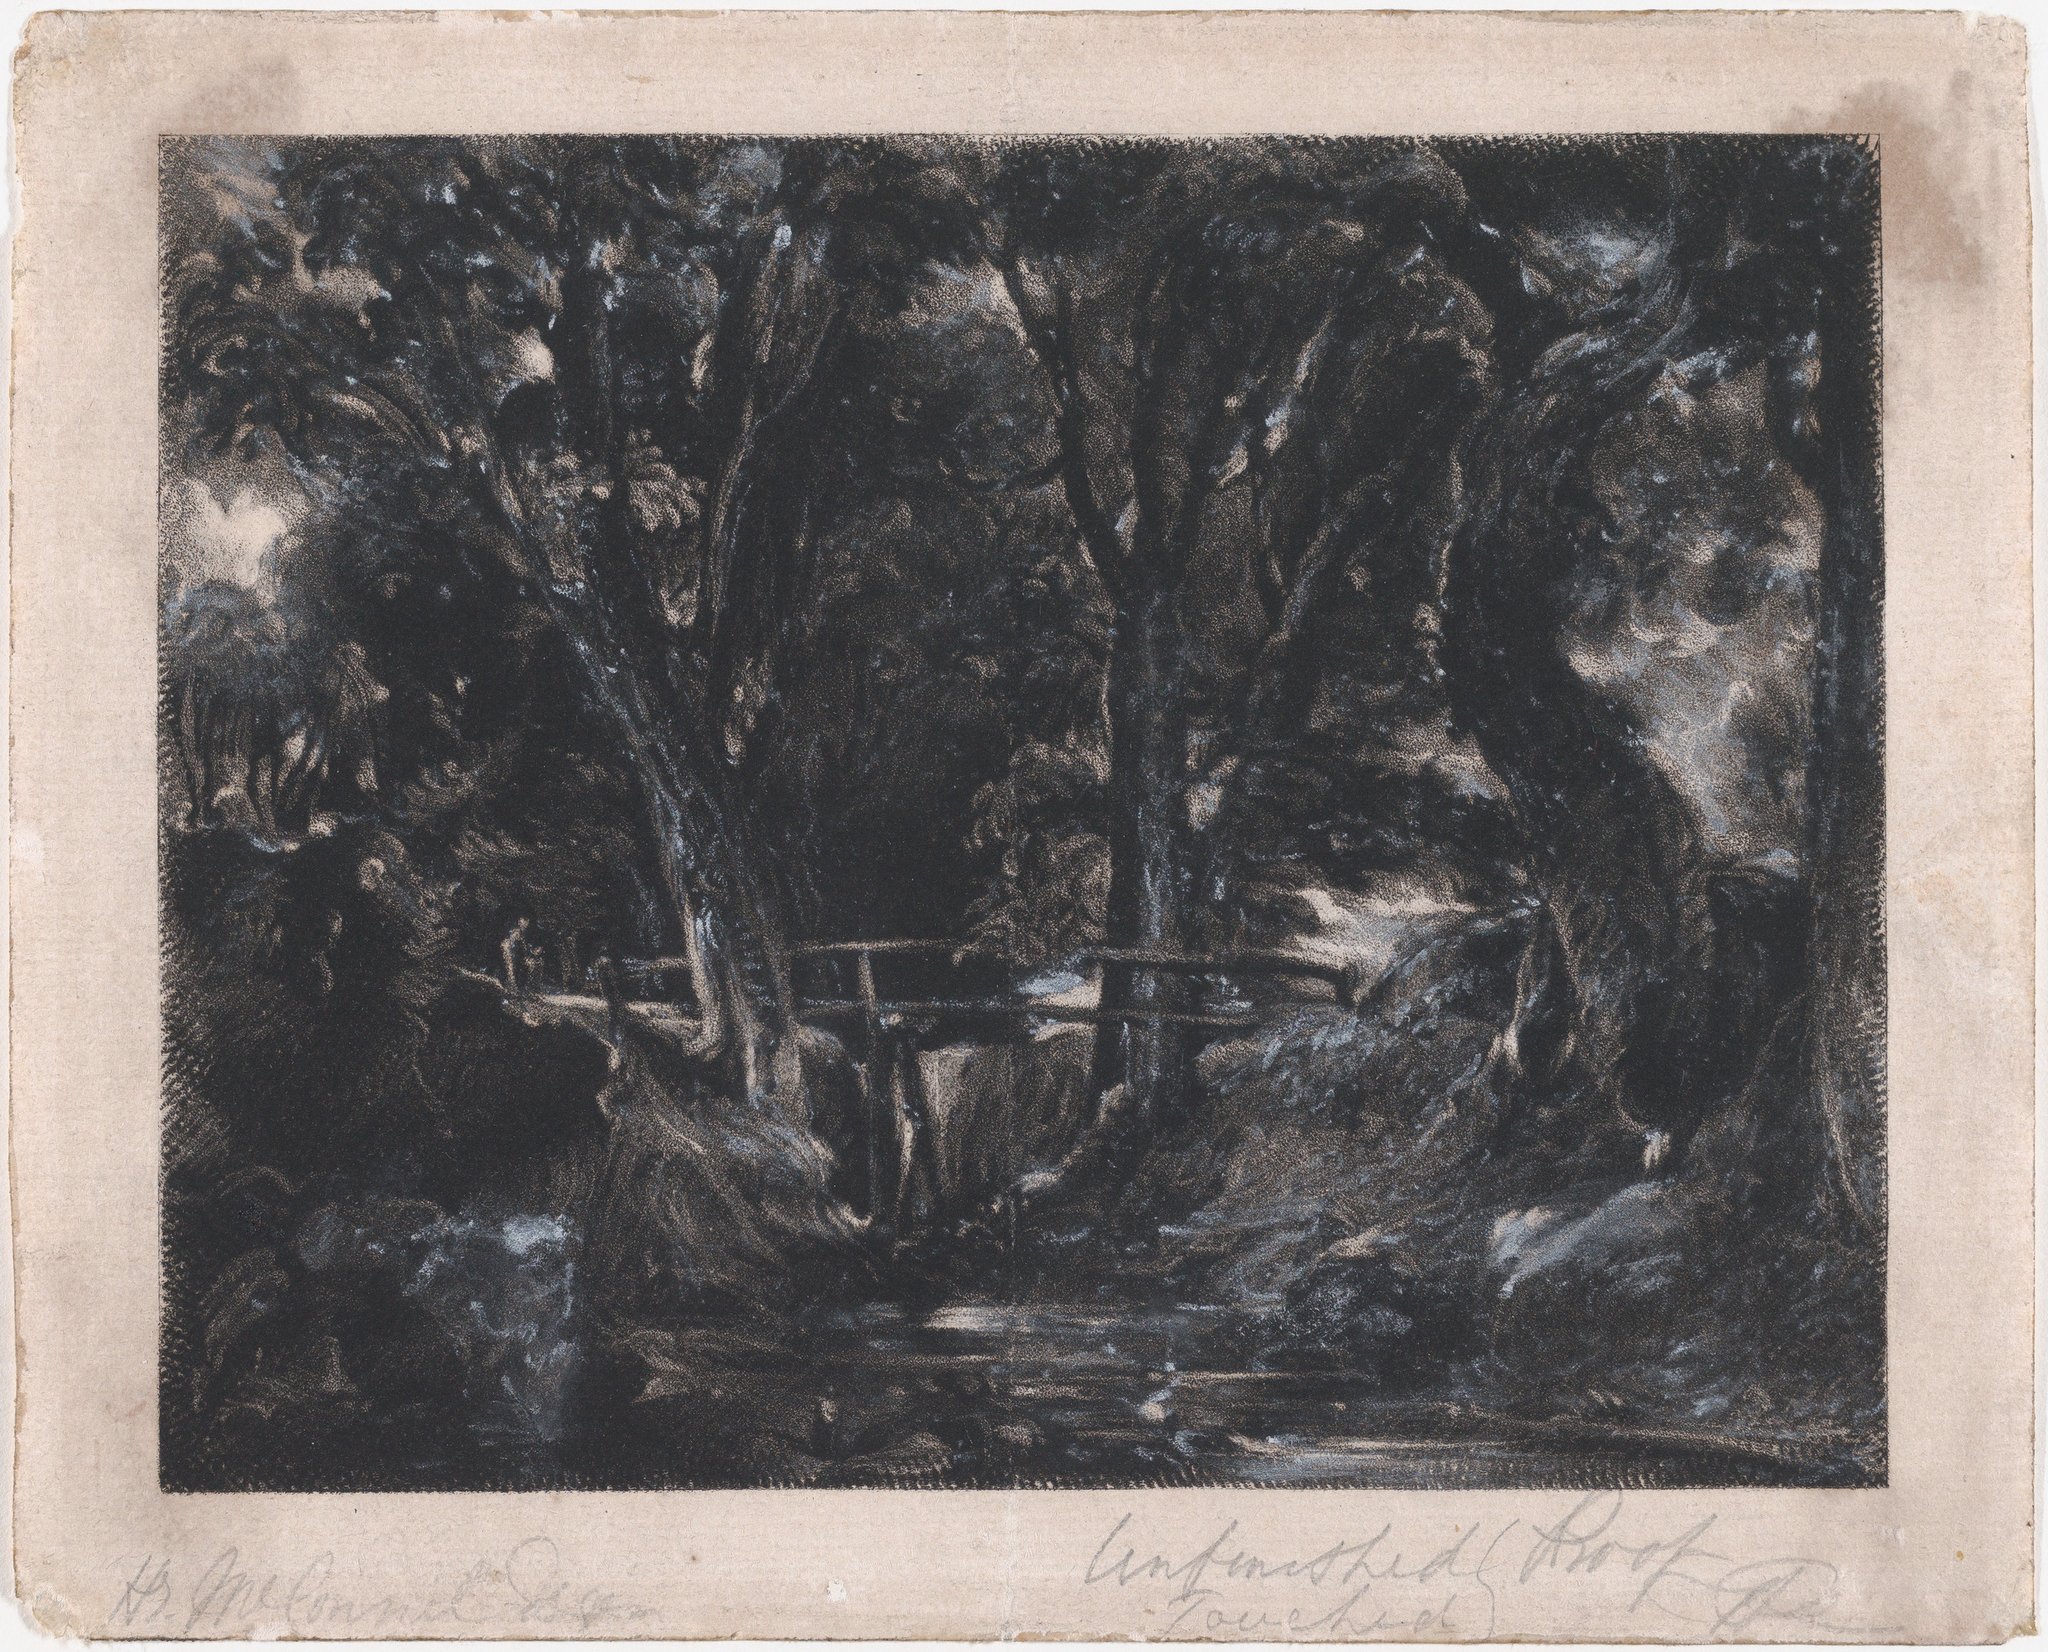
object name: print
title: A Dell, Helmingham Park, Suffolk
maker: david lucas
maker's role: artist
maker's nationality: british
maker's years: 1802-1881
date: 1830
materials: chalk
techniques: mezzotint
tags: bridges,parks,trees